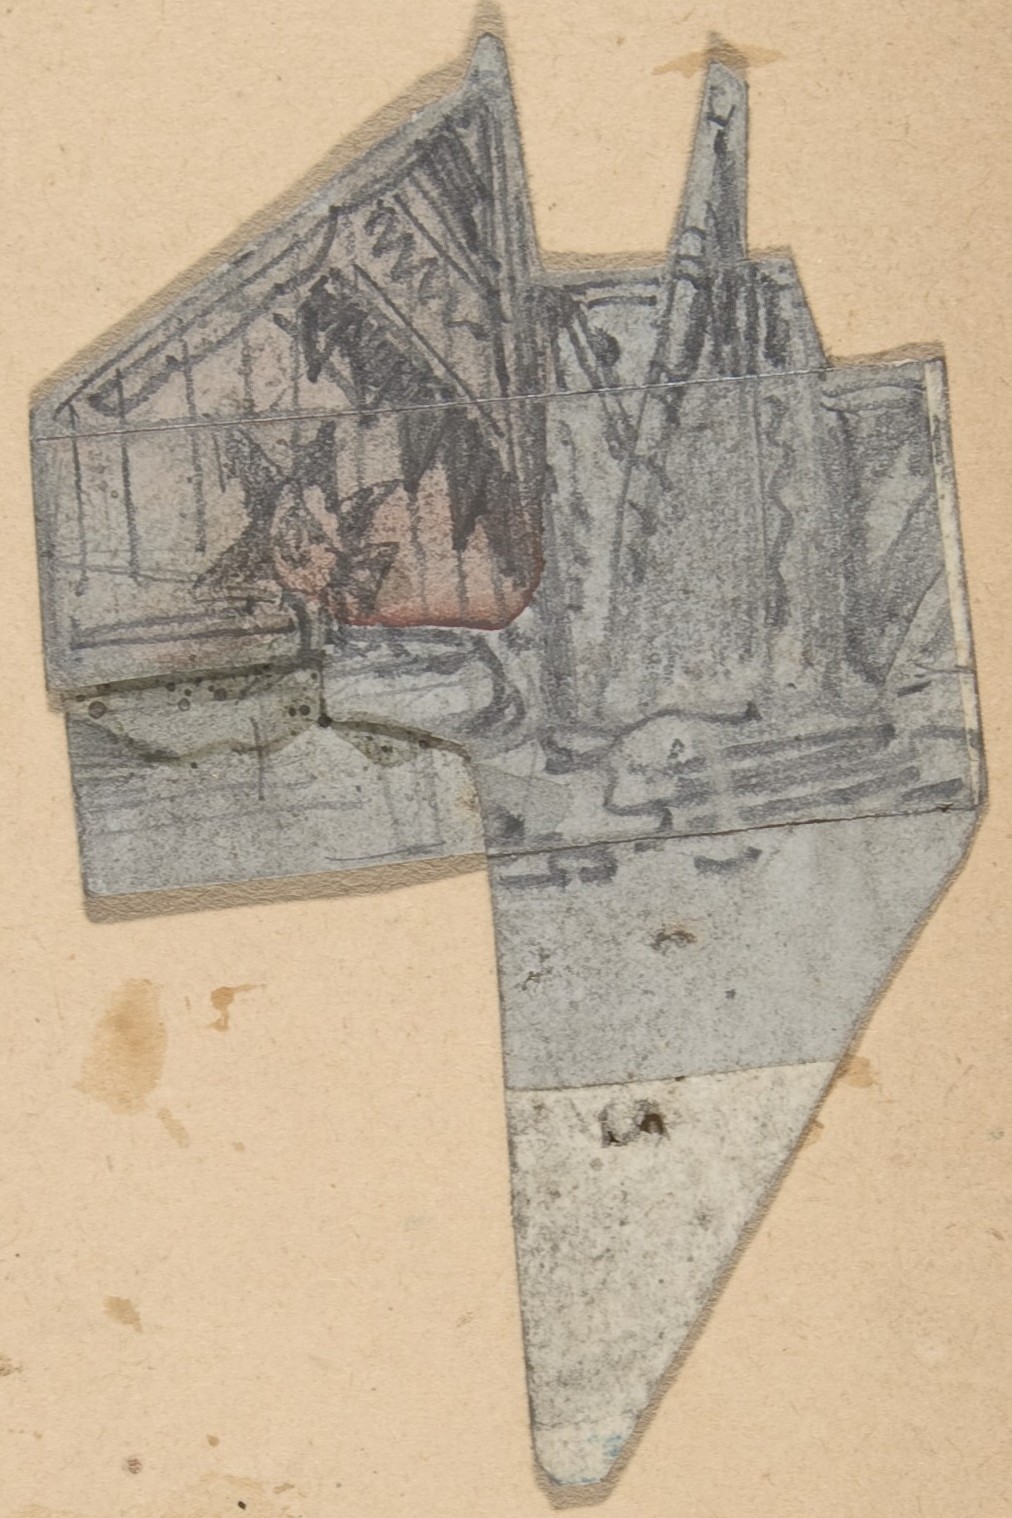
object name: drawing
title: Design for a Stage Set at the Opéra, Paris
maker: eugène cicéri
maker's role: artist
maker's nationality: french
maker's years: 1813-1890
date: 1830-1890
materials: graphite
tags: stage design